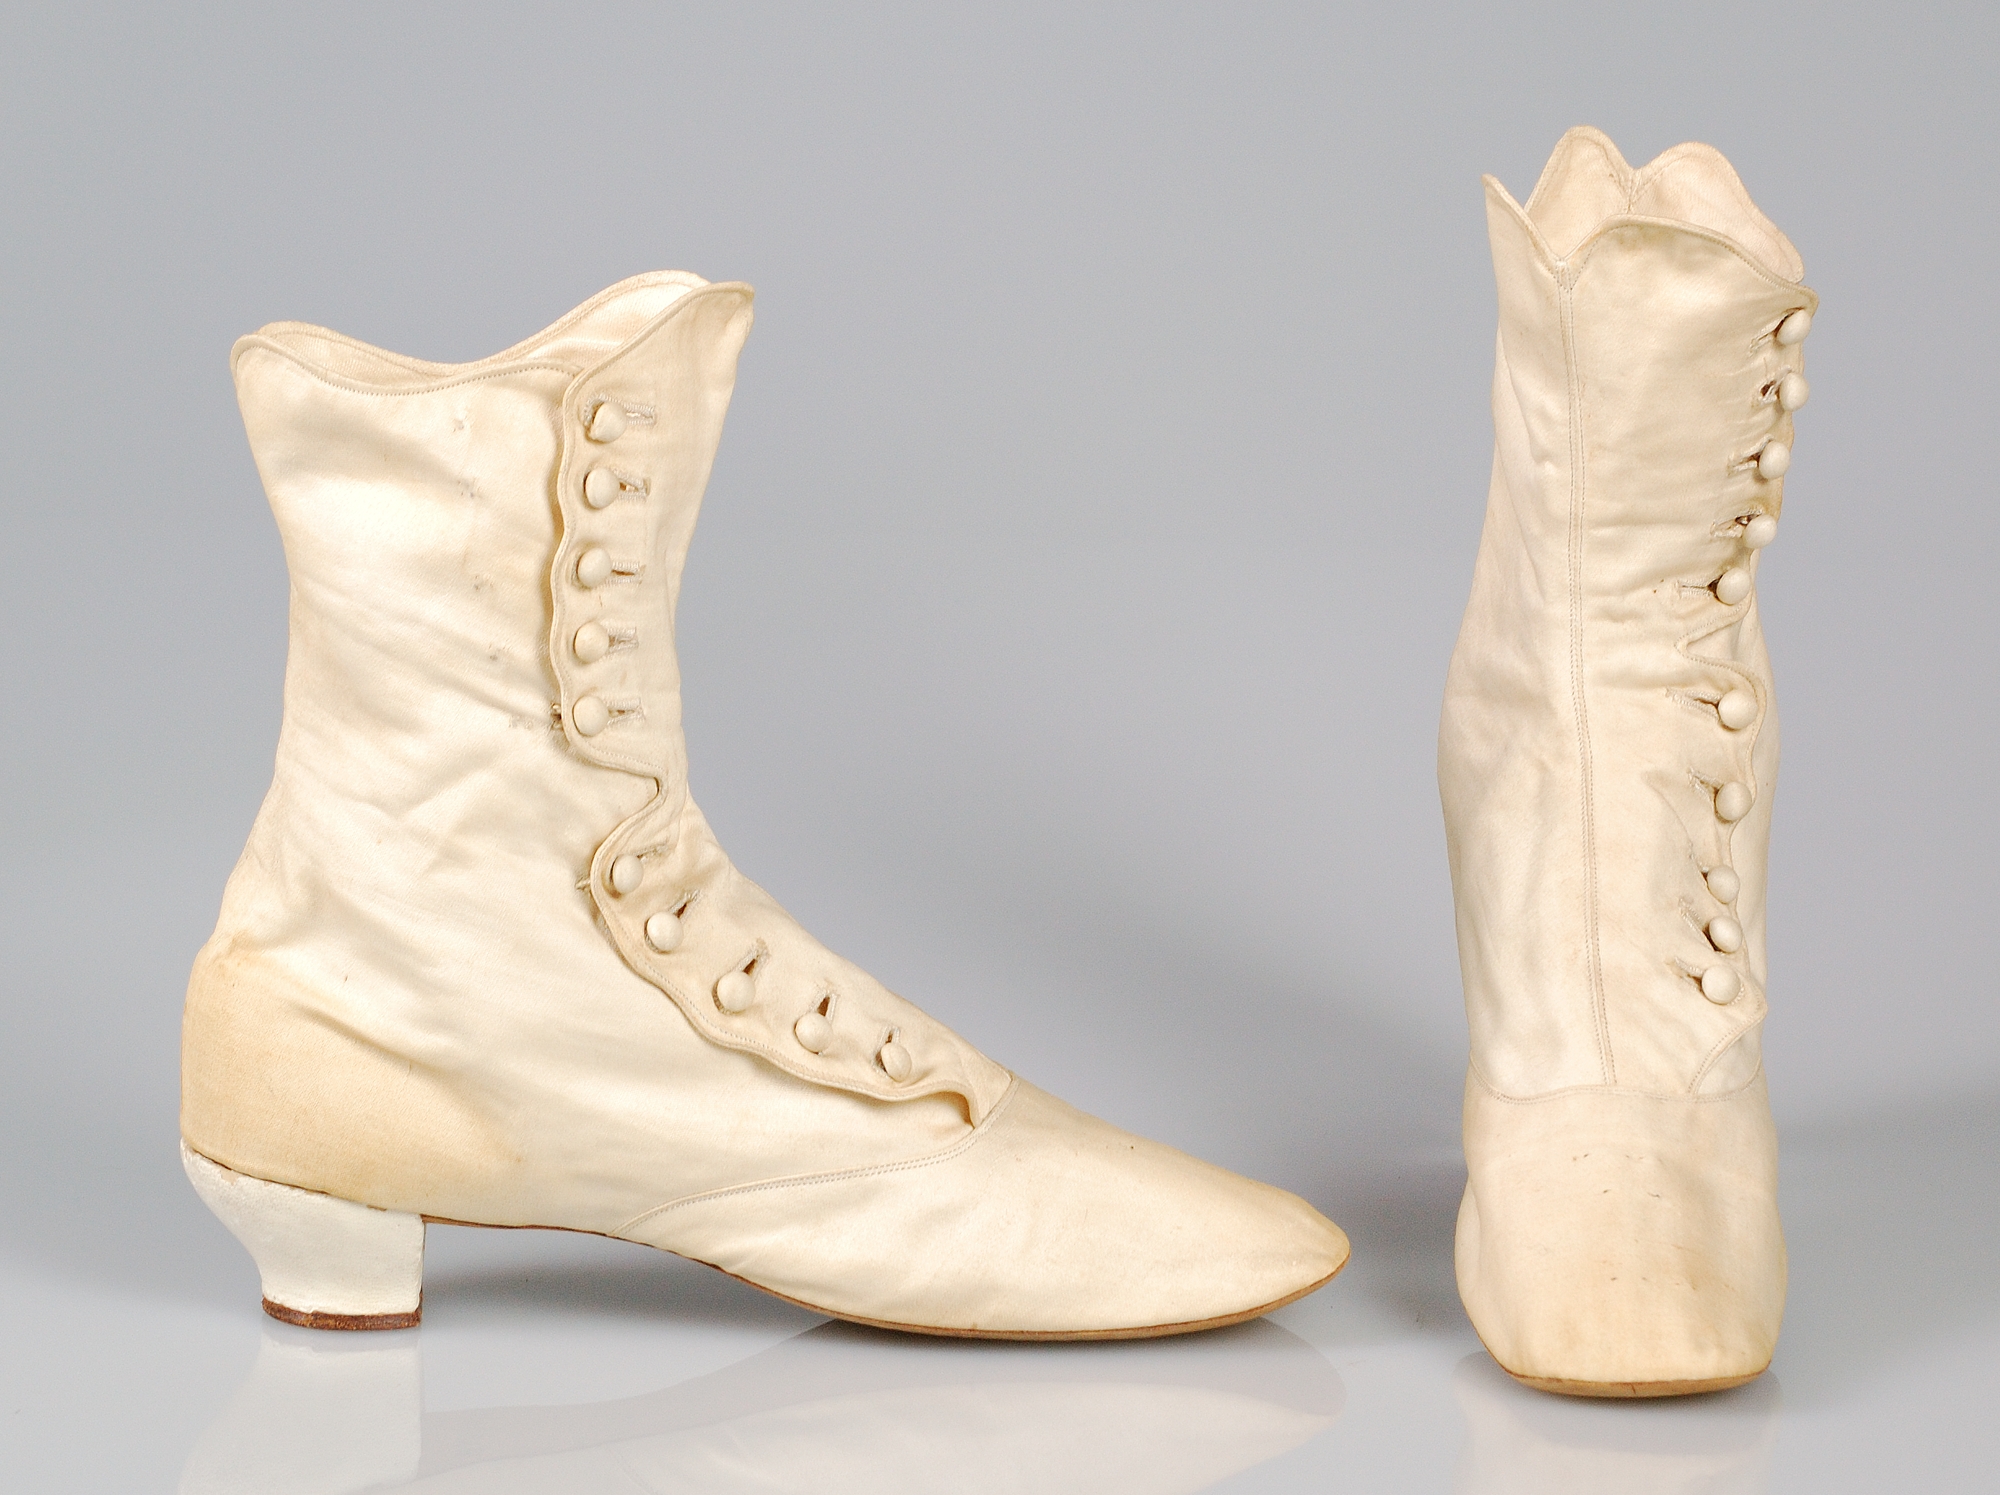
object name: boot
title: Boots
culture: american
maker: excelsior button & boot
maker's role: maker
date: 1870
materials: cotton